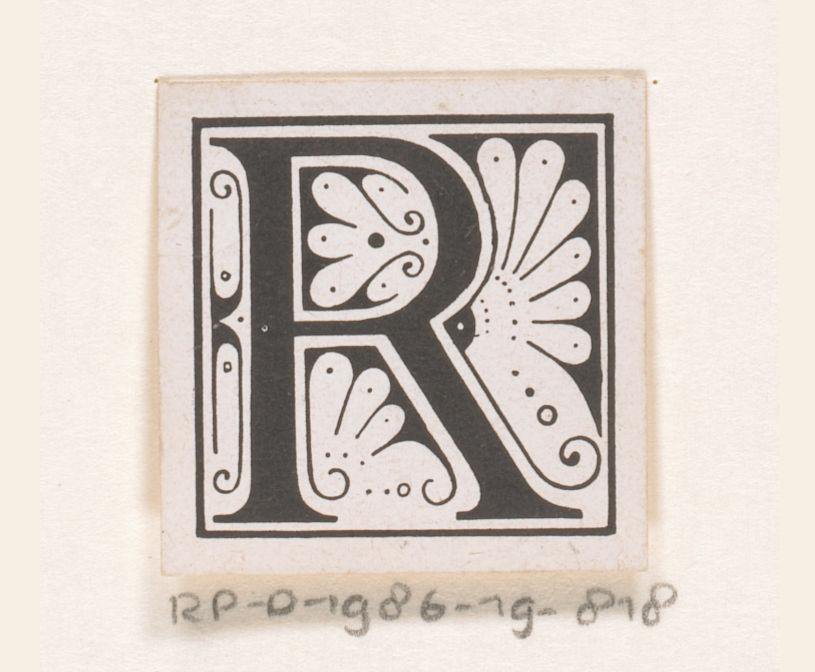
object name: photomechanical print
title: Initiaal R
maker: reinier willem petrus de vries (1874-1953)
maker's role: draughtsman, print maker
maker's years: 1874-1953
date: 1904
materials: paper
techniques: printing block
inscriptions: collector's mark: ‘R:MVS.’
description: Het initiaal is gebruikt voor: Veth, Jan. Jozef Israëls en zijn kunst. Arnhem en Nijmegen: Gebroeders E&M Cohen, 1904.